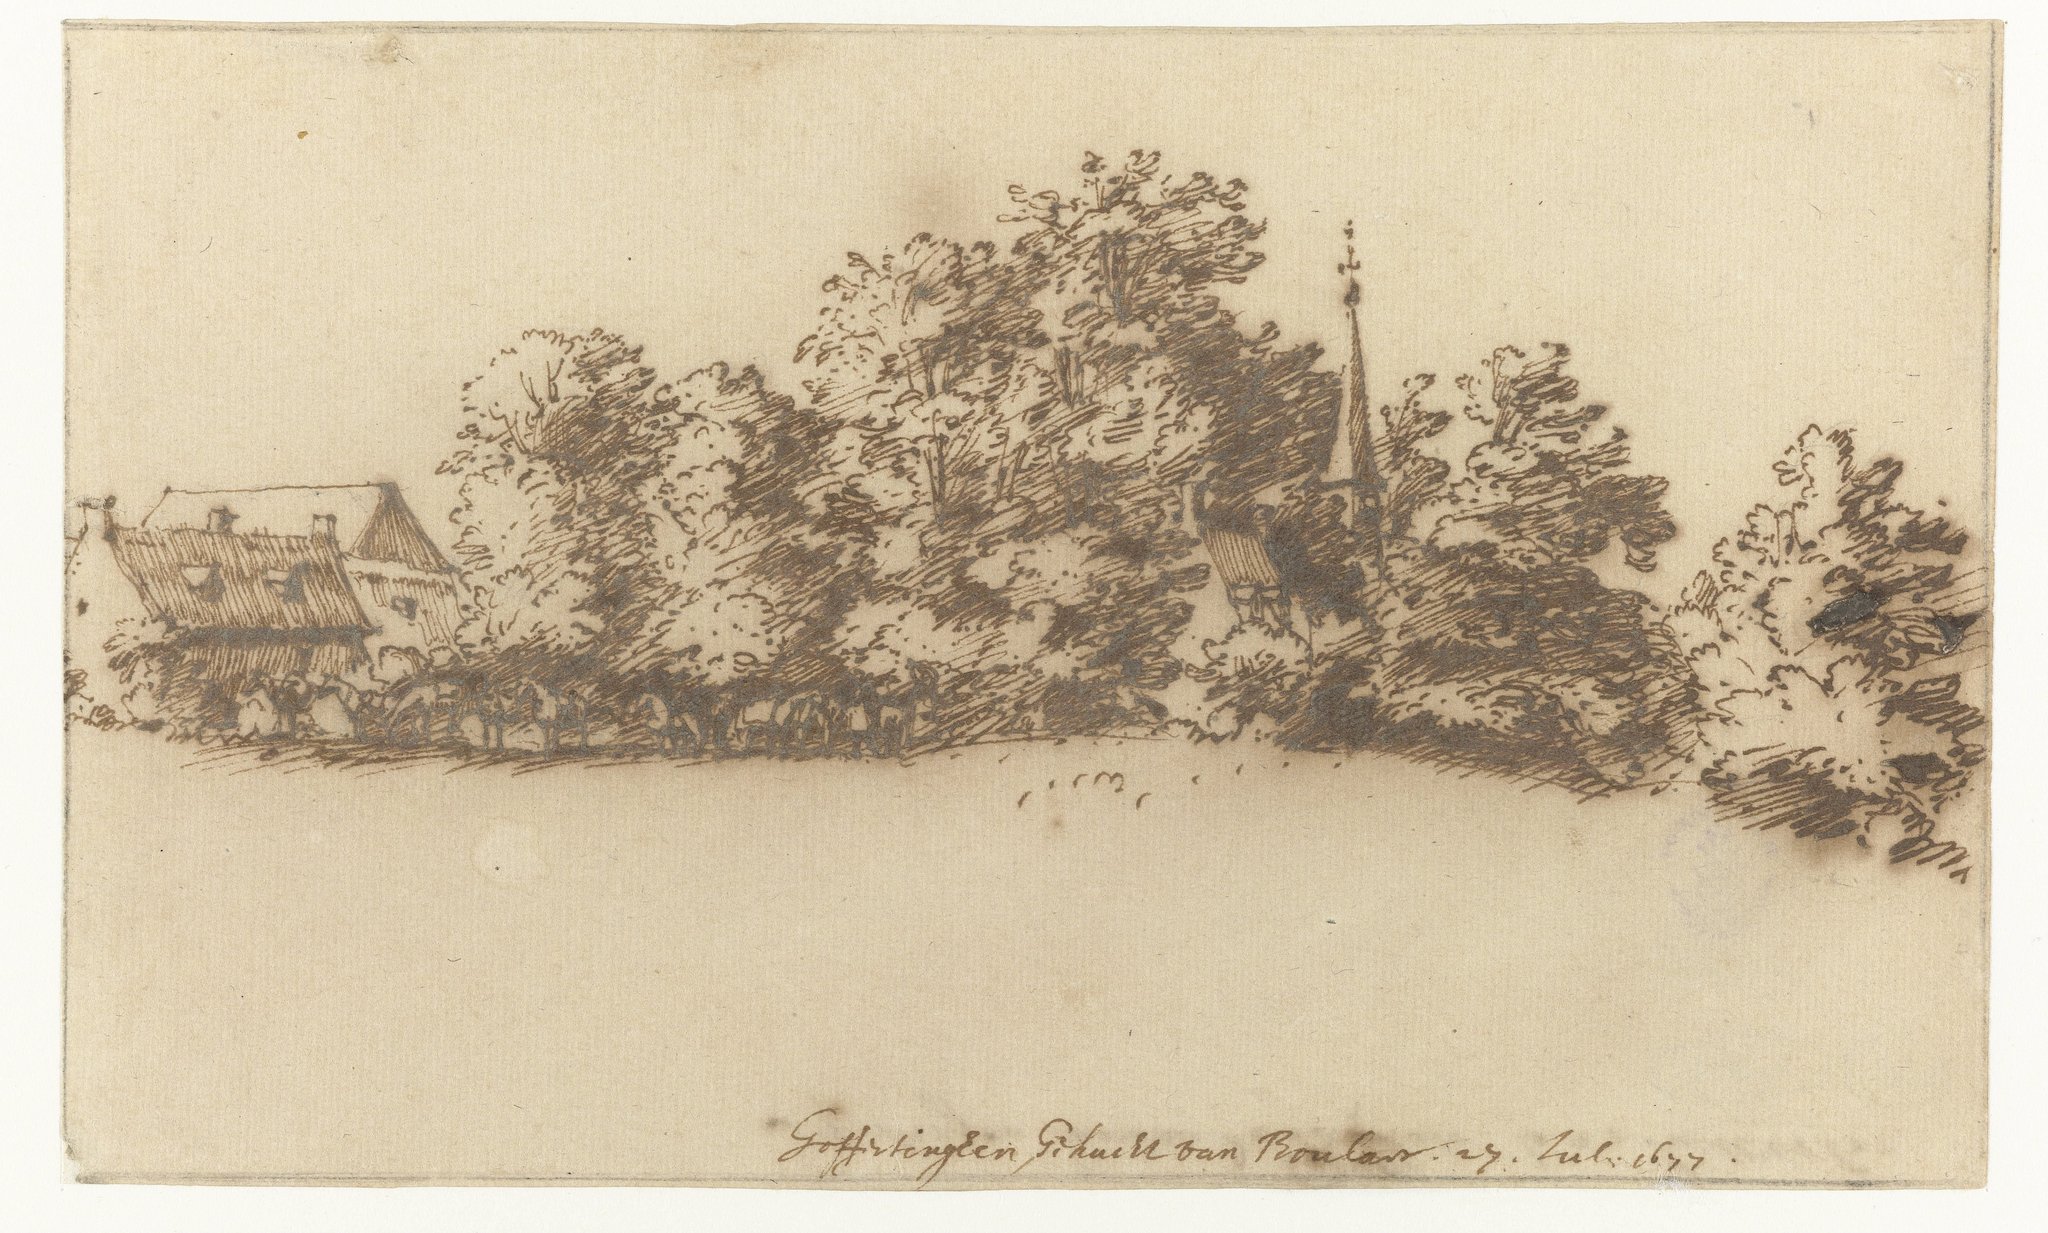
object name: drawing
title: Goeferdinge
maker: constantijn huygens (ii)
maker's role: draughtsman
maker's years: 1628-1697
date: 1677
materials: ink, paper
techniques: pen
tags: prospect of village, silhouette of village